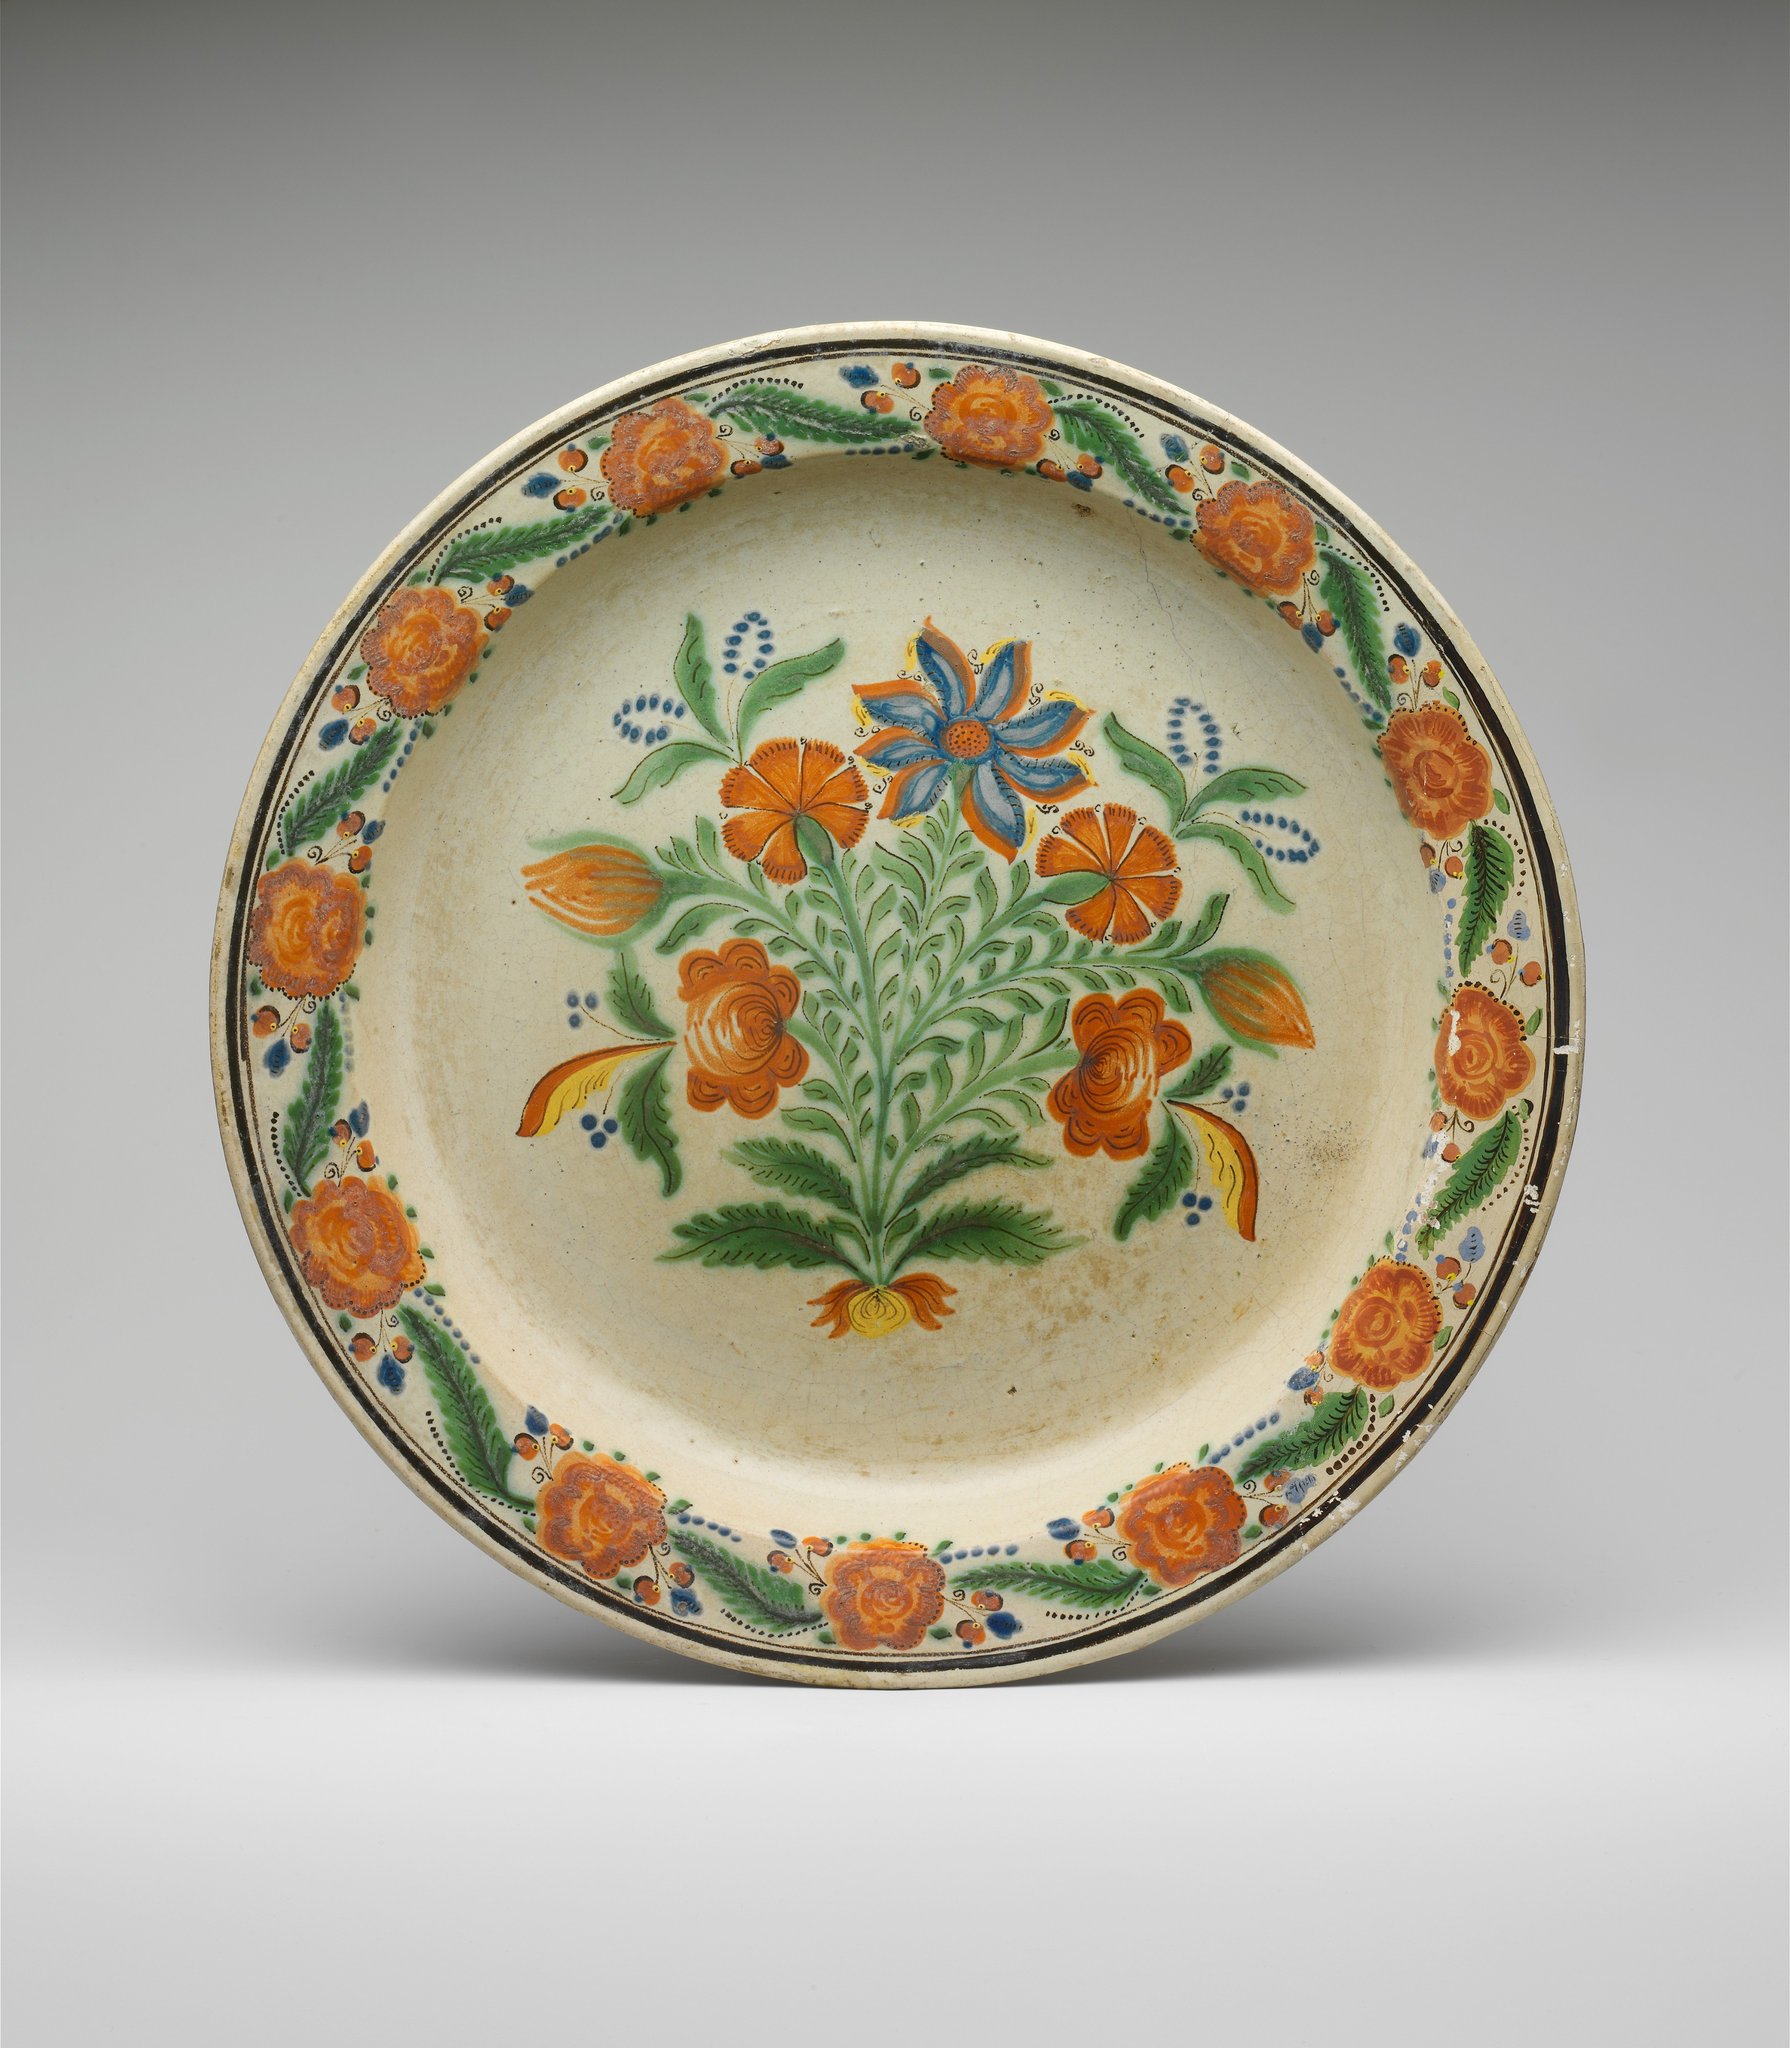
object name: plate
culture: mexican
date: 1840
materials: earthenware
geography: mexico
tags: flowers